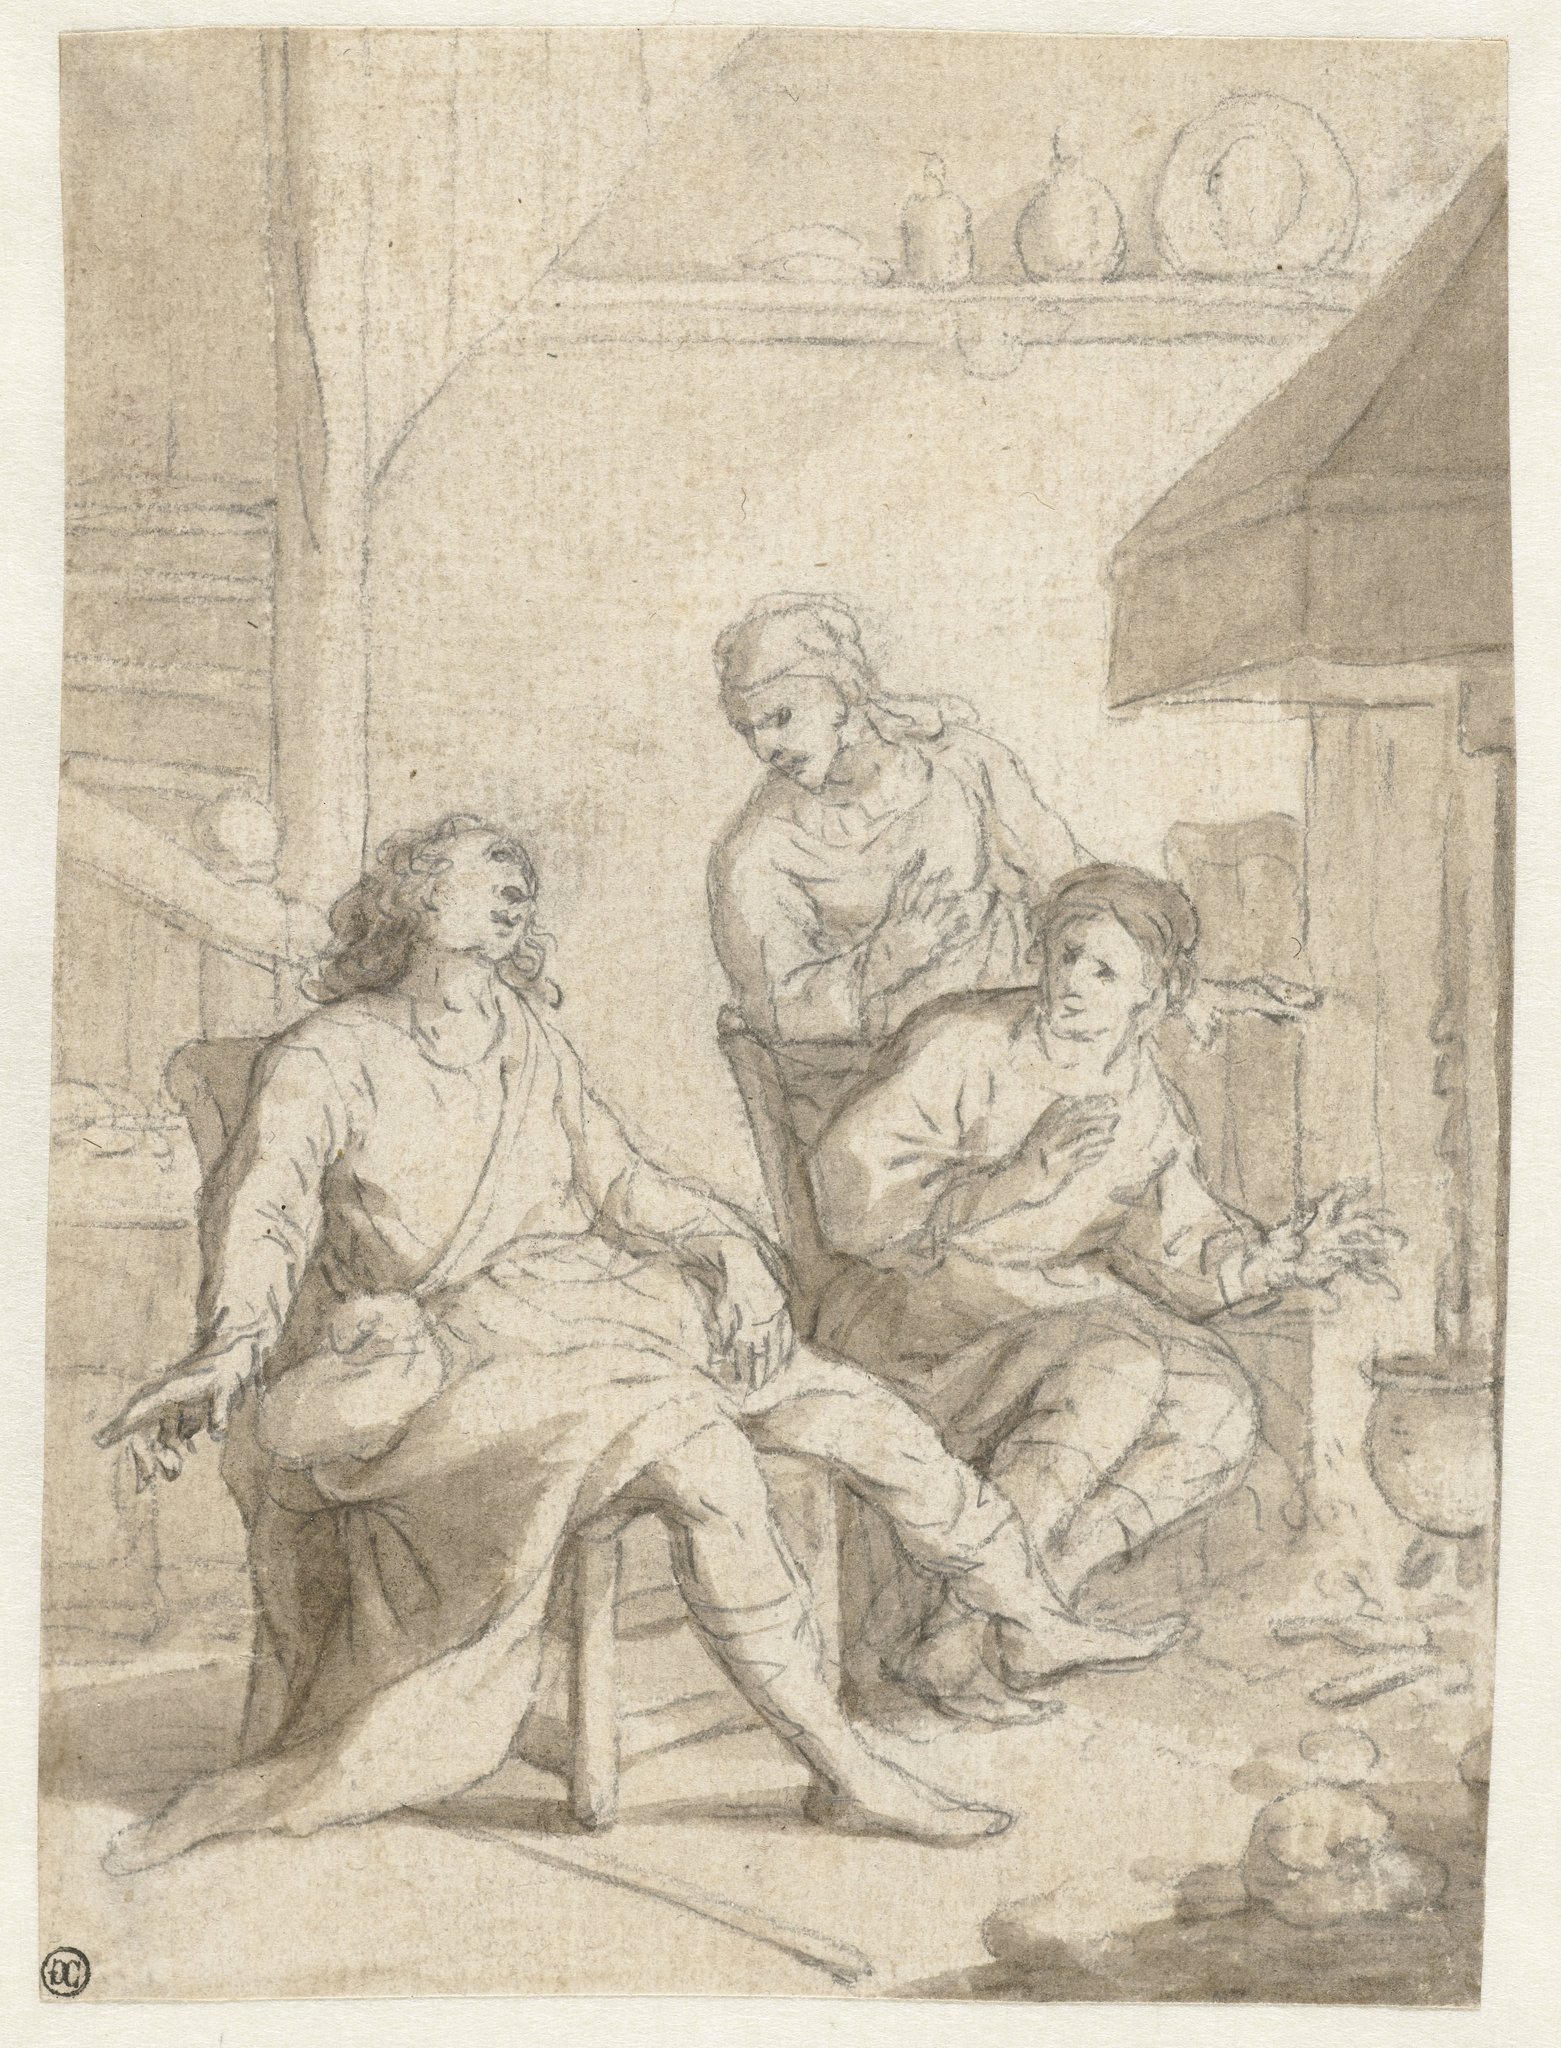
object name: drawing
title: Man en twee vrouwen in een keuken bij het vuur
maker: Anonymous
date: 1650-1699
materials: chalk, graphite, paper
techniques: brush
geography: northern netherlands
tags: kitchen-interior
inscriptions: annotation: ‘Samuel hogstraeten’